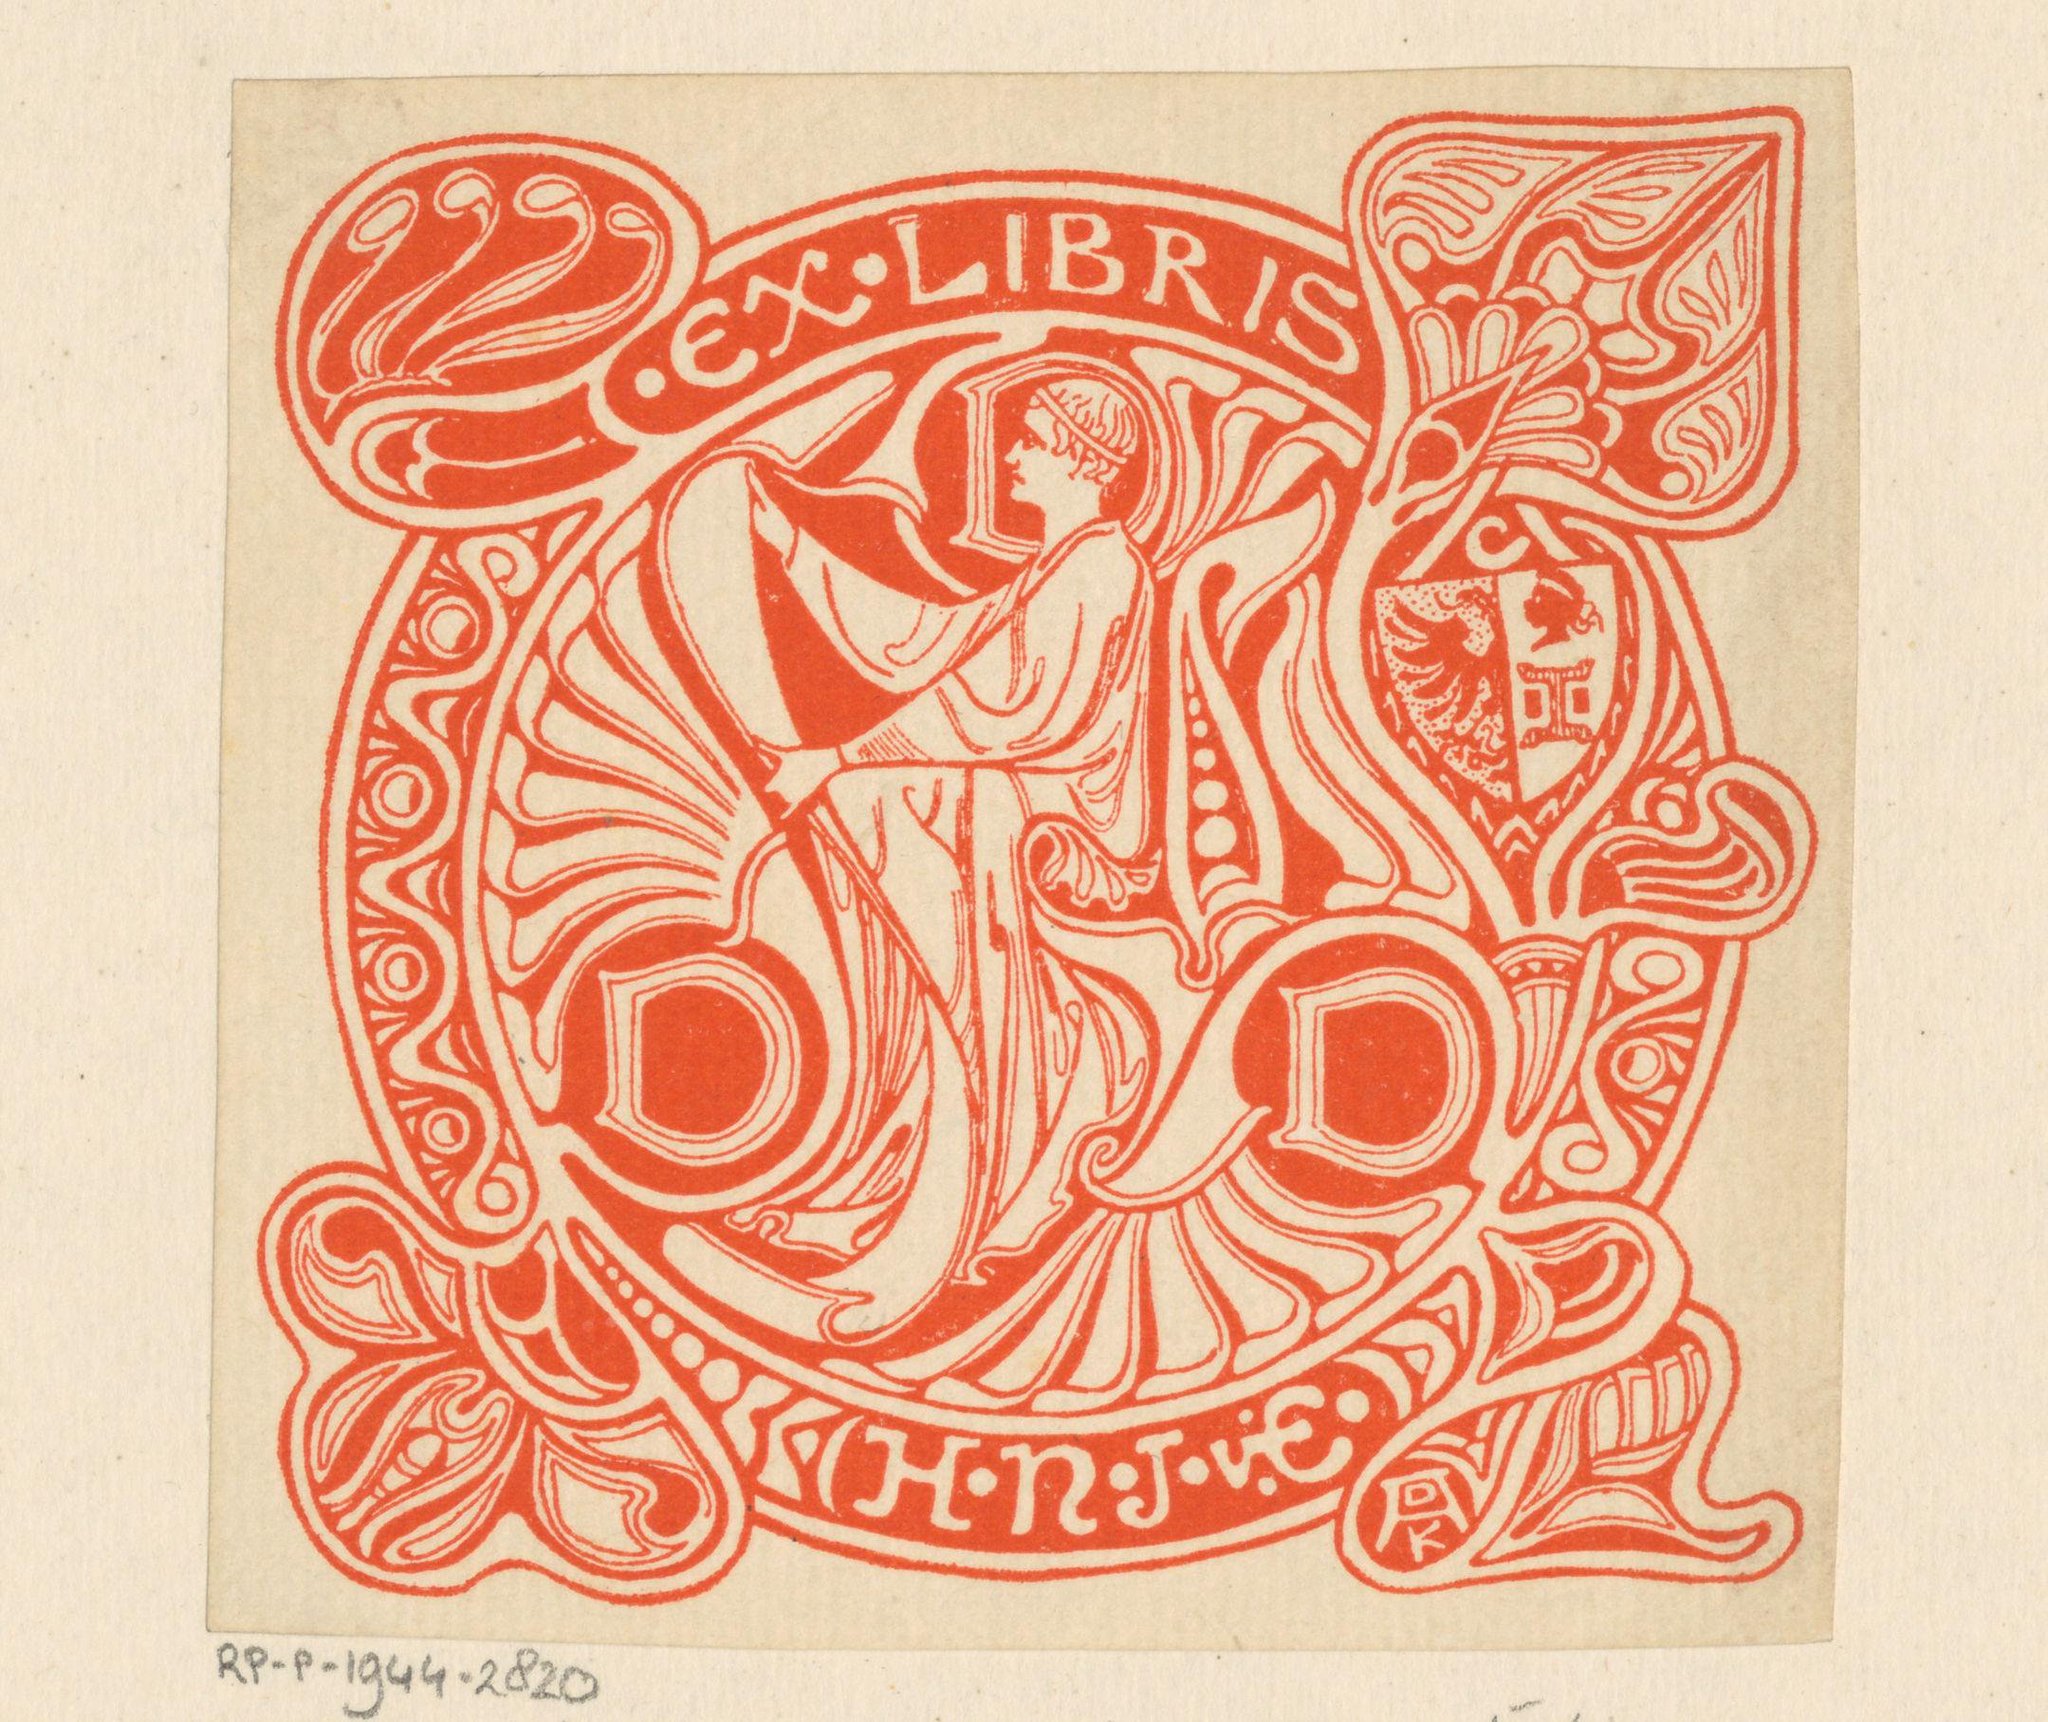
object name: bookplate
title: Ex libris van H.N.J. van Eelde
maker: antoon derkinderen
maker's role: draughtsman, painter, print maker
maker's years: 1859-1925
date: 1869-1913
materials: paper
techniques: printing block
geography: netherlands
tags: scholar, philosopher, armorial bearing, heraldry